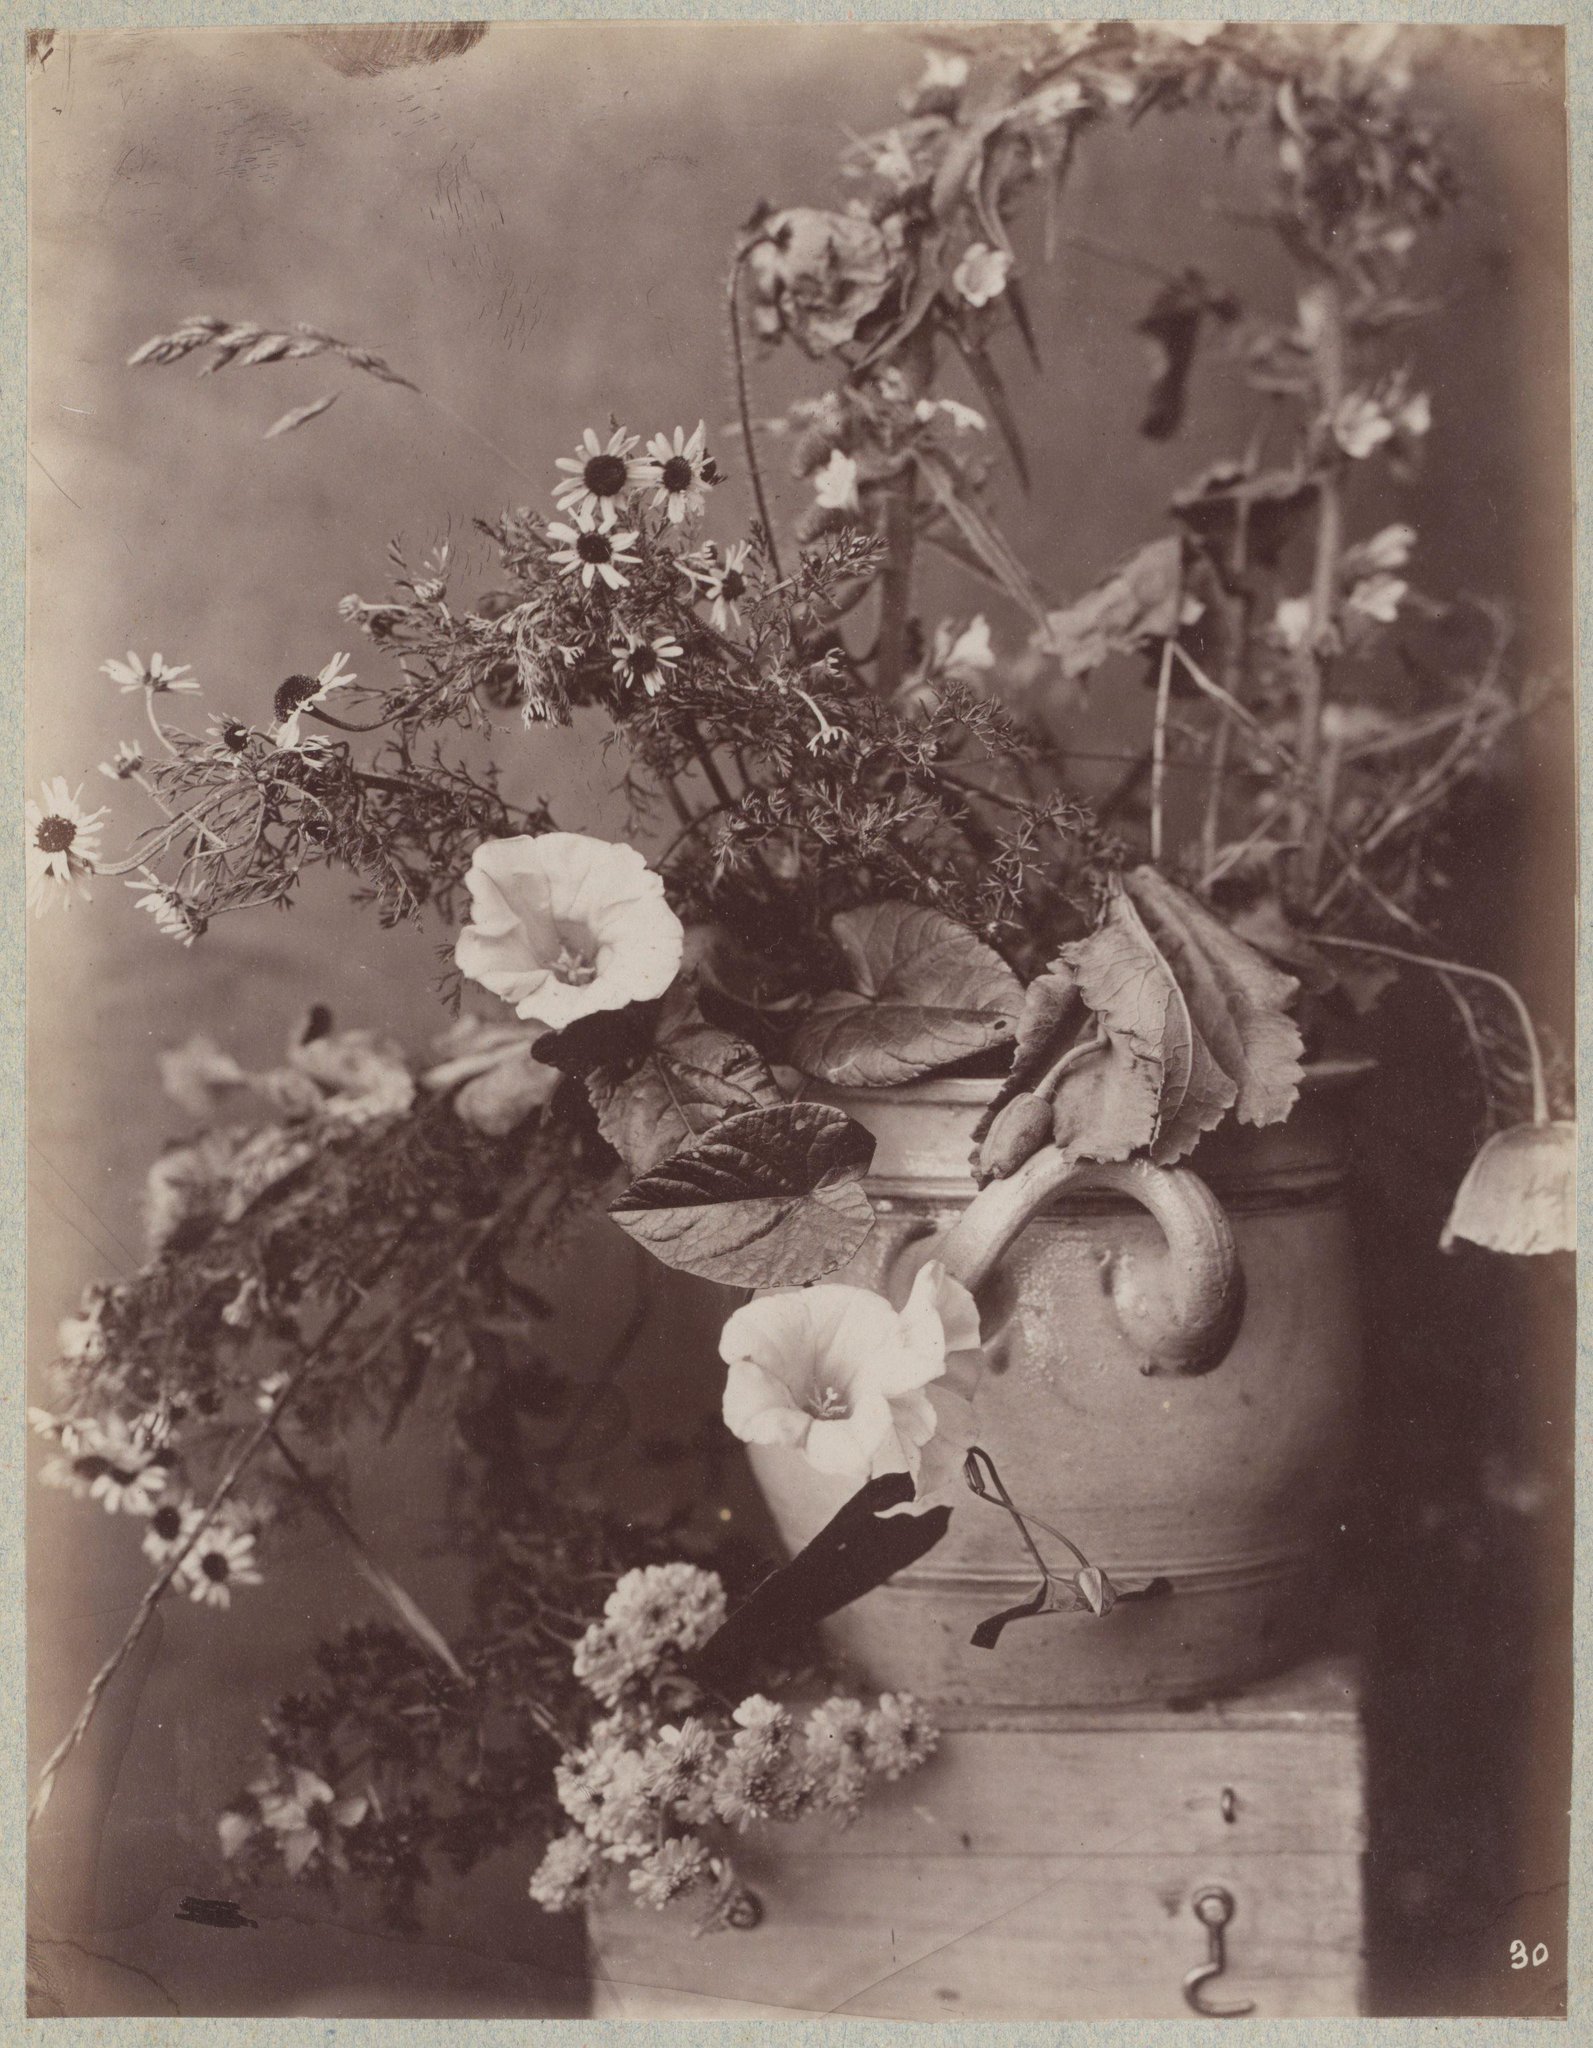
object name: photograph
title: Bloemstudie met Keulse pot op kist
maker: a. calavas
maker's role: publisher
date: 1875-1895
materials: cardboard, photographic support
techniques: albumen print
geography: paris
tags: flowers, container of ceramics: jar, jug, pot, vase, chest, coffer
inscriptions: collector's mark: Lugt 3937, number: ‘30’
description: Onderdeel van Verzamelband met foto's van bloemstudies.